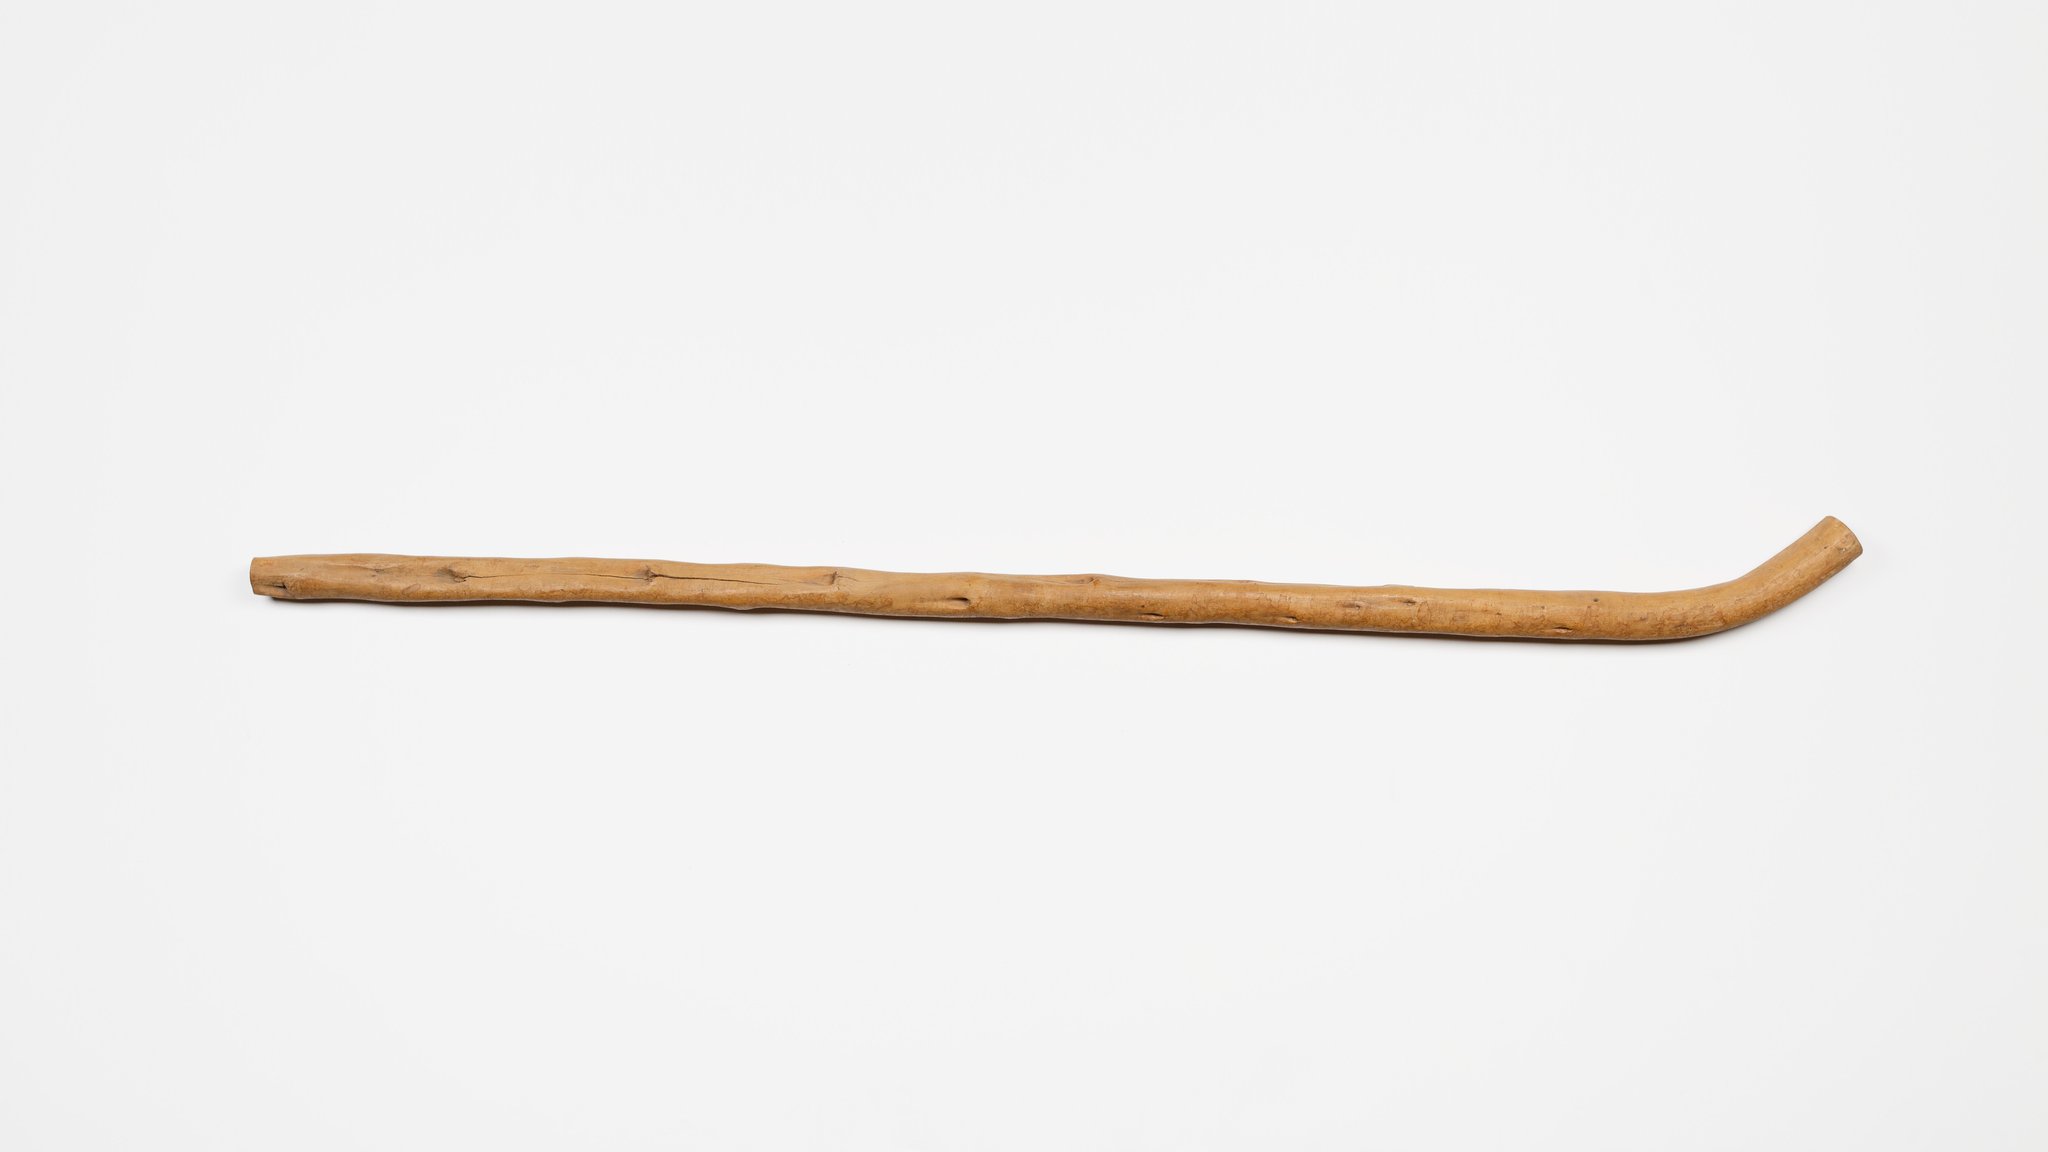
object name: staff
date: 2124-1981 BCE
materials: wood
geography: egypt